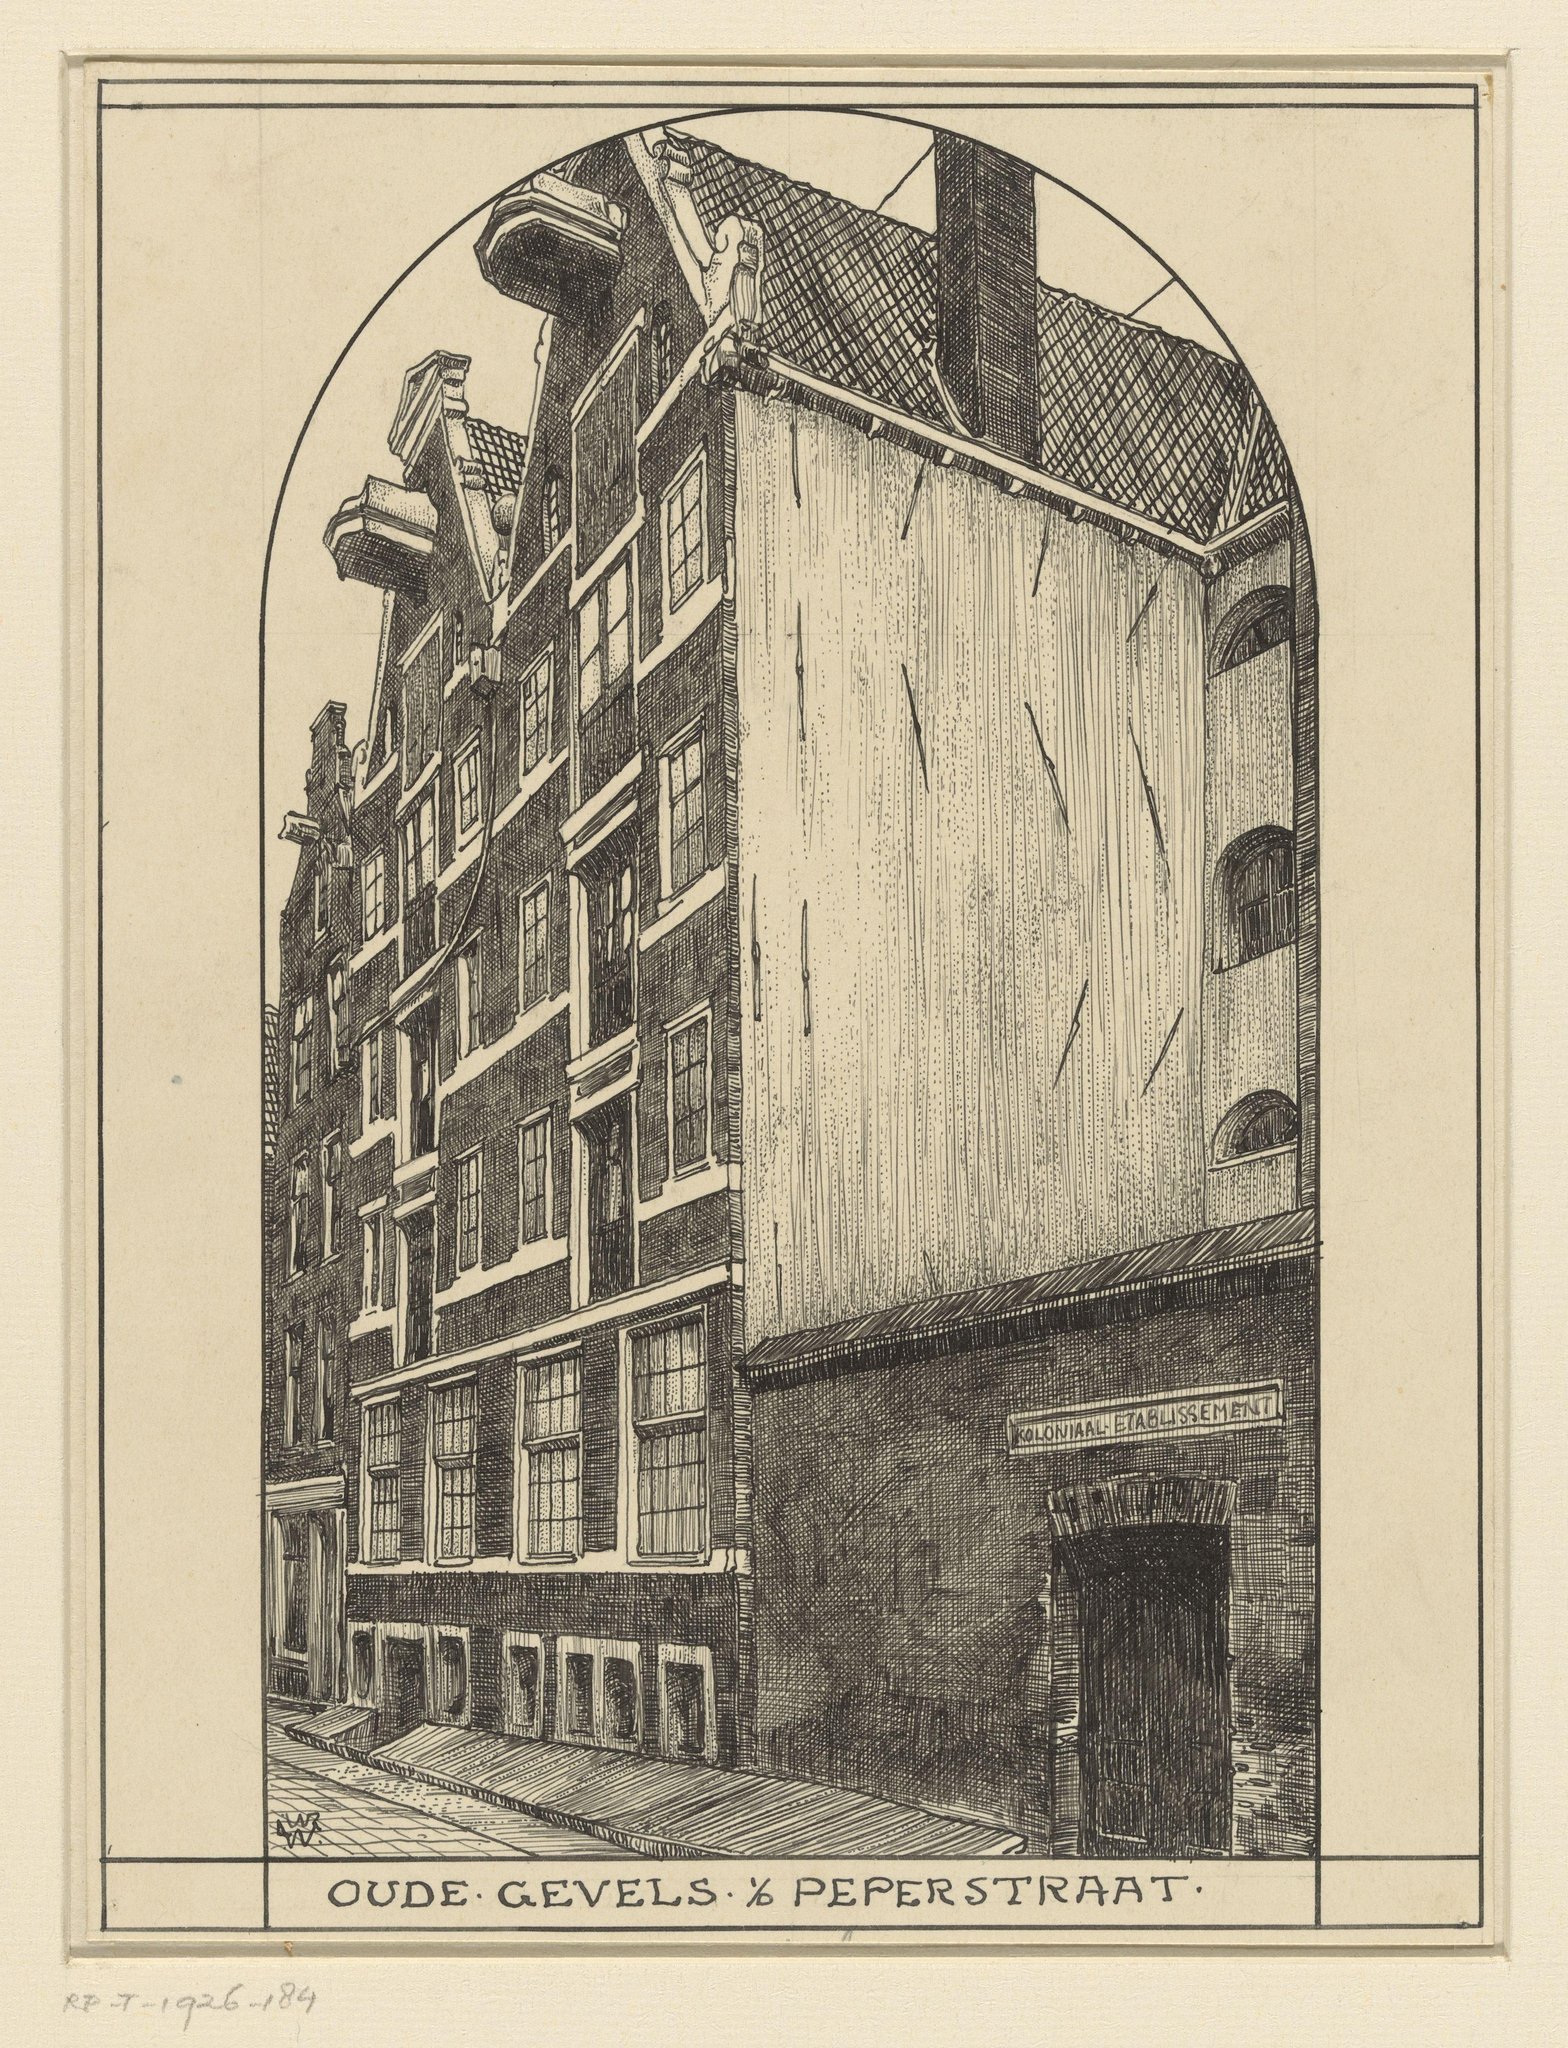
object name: drawing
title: Oude gevels in de Peperstraat te Amsterdam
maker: willem wenckebach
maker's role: designer, draughtsman, painter, print maker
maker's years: 1860-1937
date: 1870-1926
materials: ink, paper, pencil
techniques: pen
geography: amsterdam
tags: street